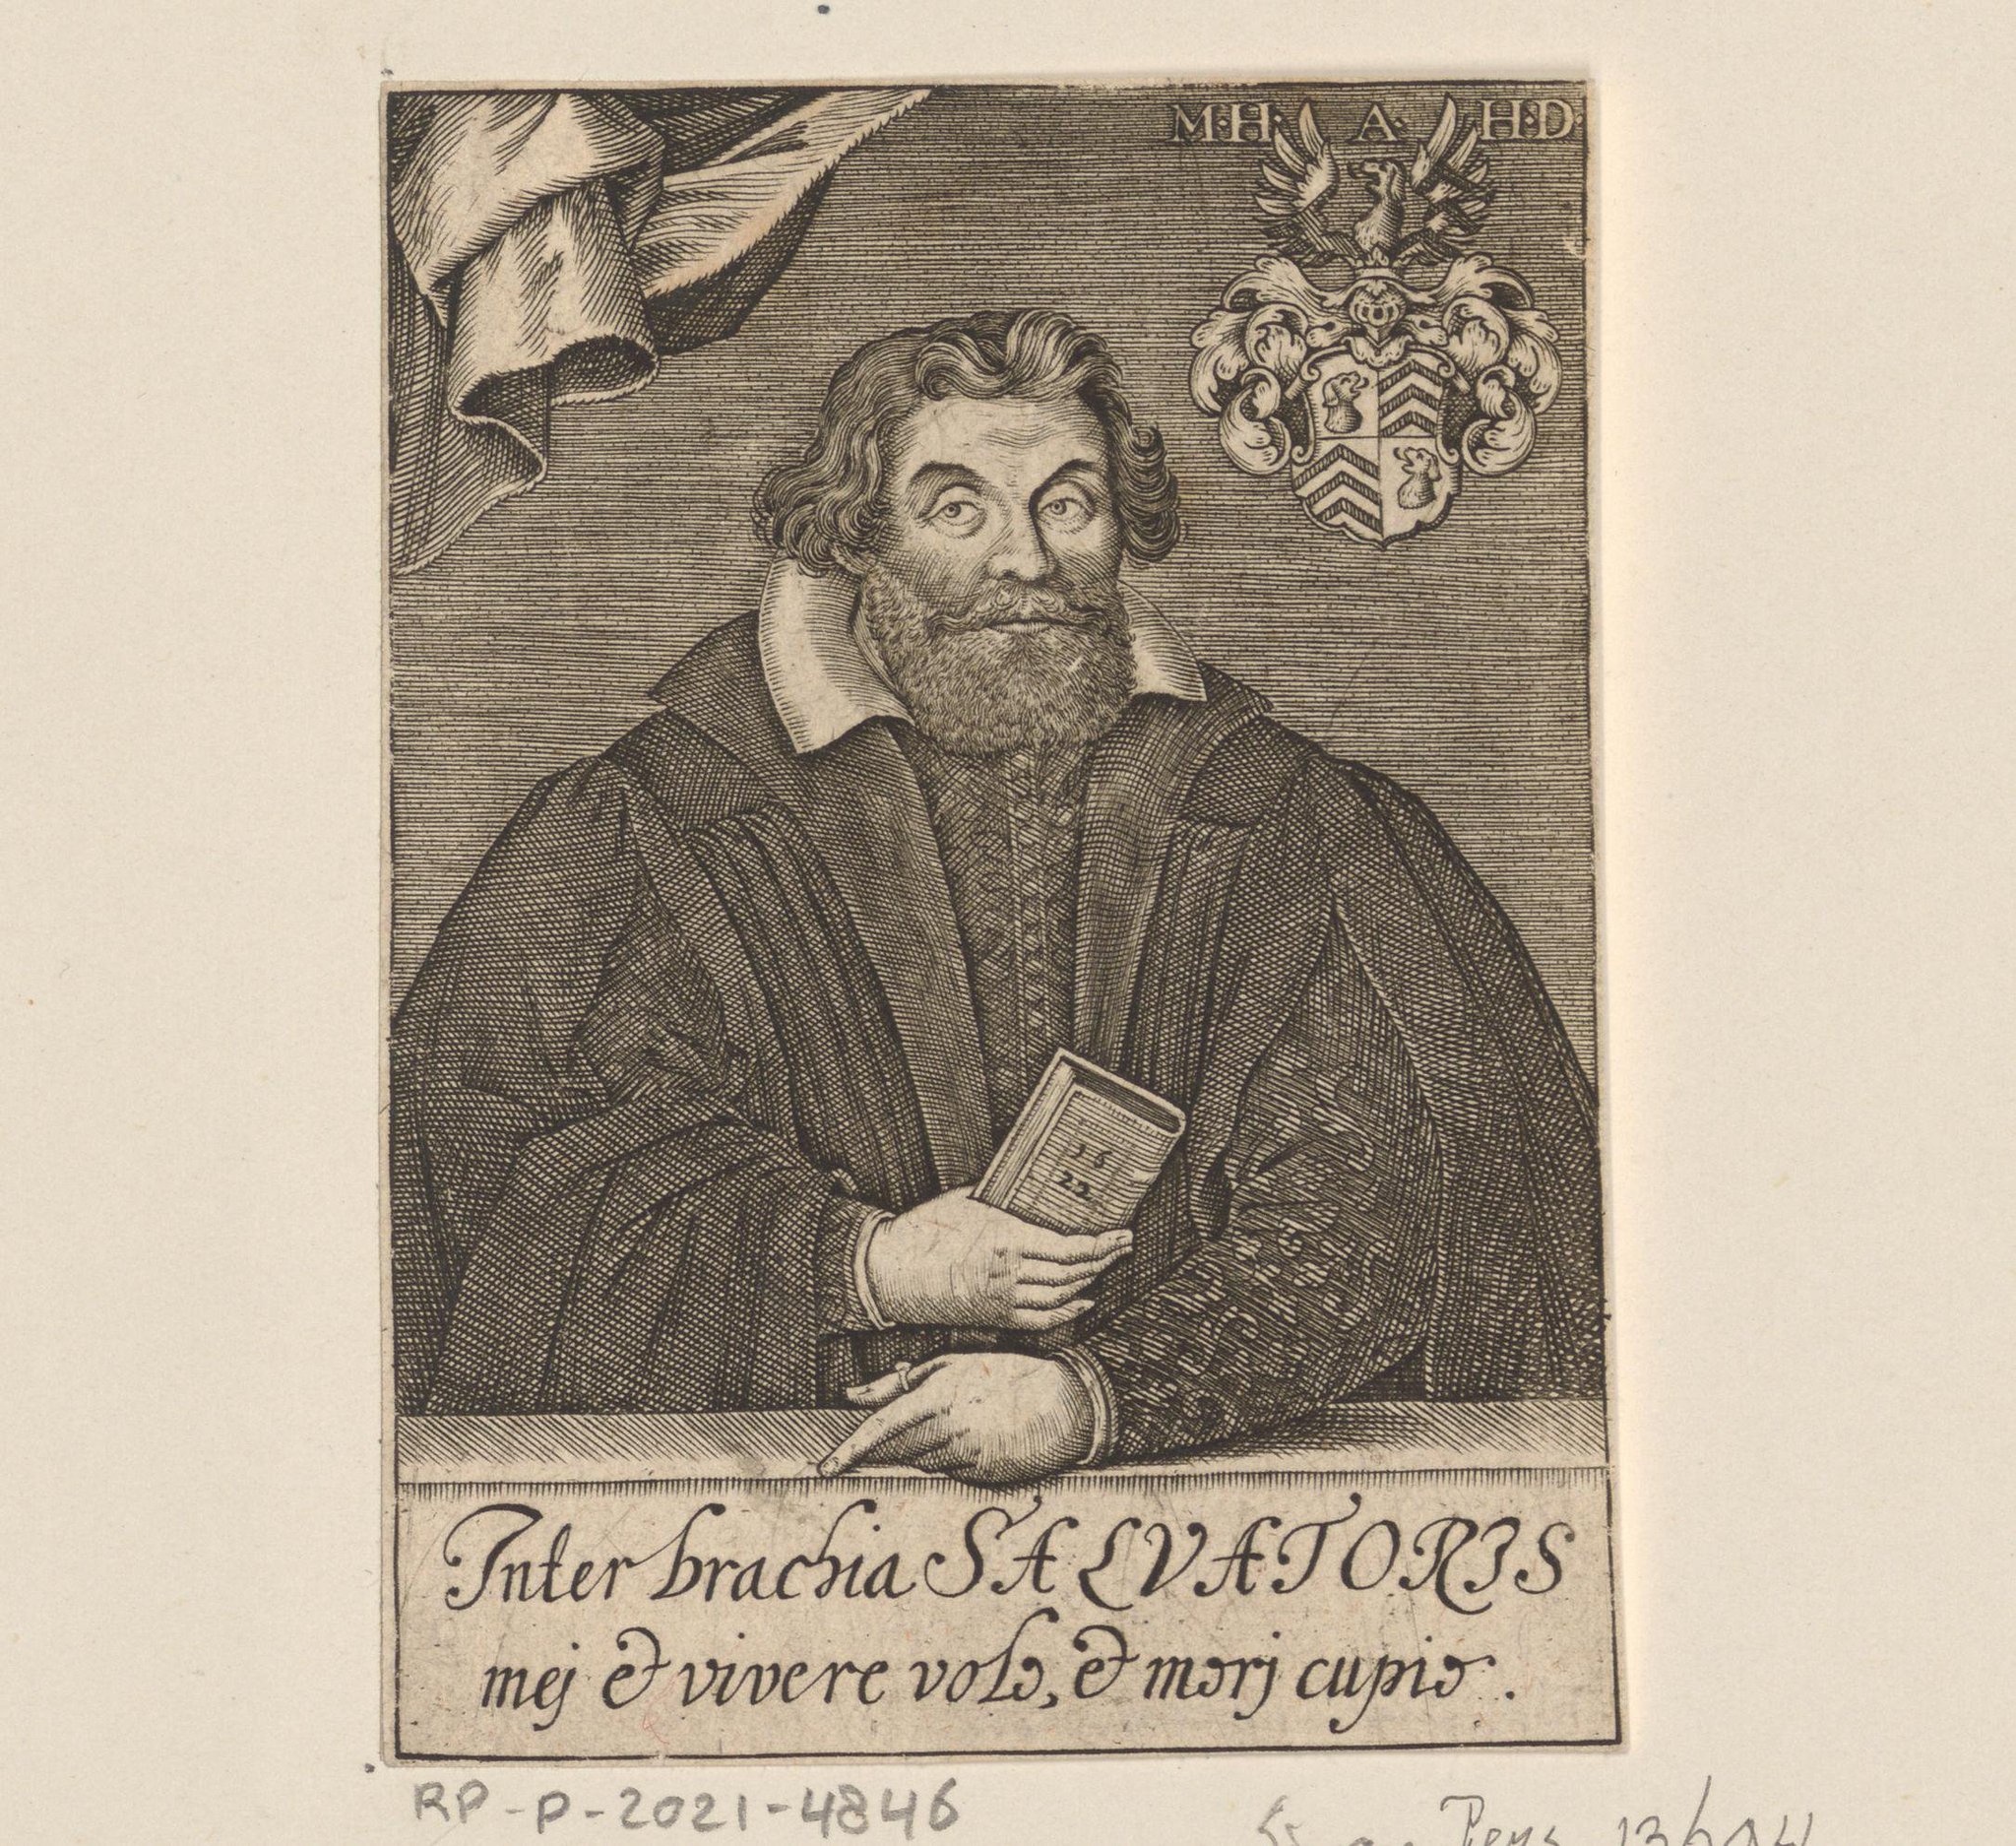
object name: print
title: Portret van Matthias Hoë von Hoënegg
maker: Anonymous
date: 1650-1749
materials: paper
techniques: engraving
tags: vienna, theologian, historical persons, book, armorial bearing, heraldry